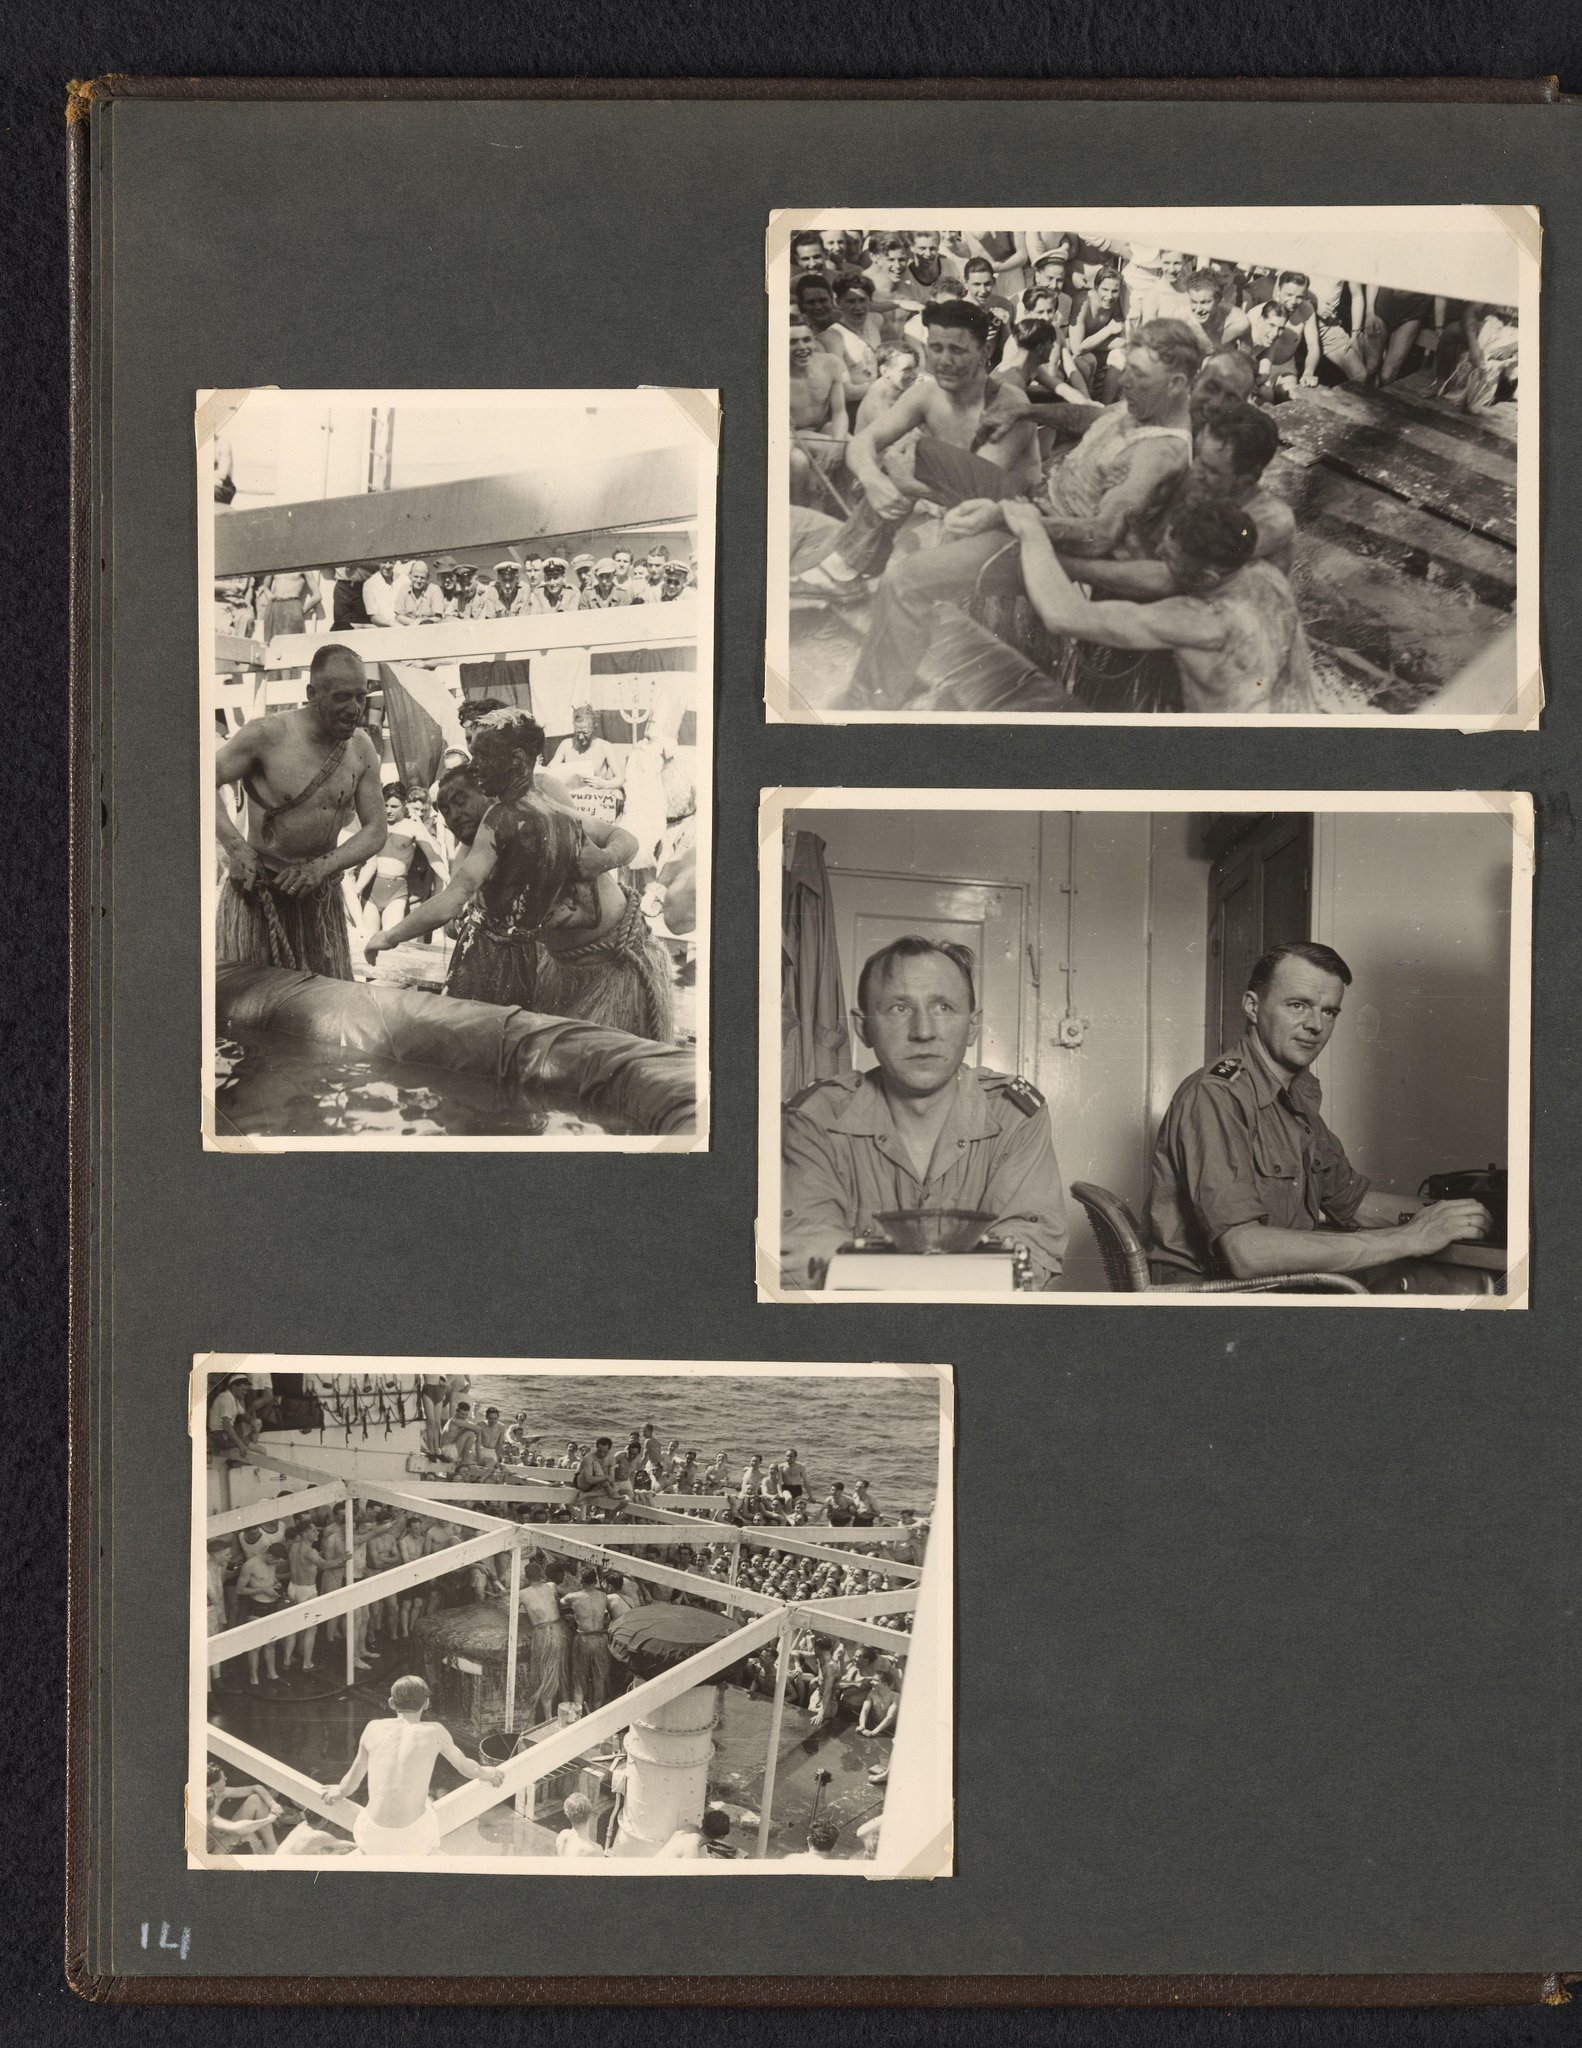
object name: album leaf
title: Aan boord vieren van het passeren van de evenaar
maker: Anonymous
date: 1947-1948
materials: cardboard, photographic support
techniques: gelatin silver print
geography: equator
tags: the company, the unit, the troop ~ military service, man dressed as woman, travesty, celebration on board while crossing the equator (neptune)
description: Albumblad met vier foto's van het vieren van het passeren van de evenaar aan boord van het schip de S.S. Waterman, onderweg naar Nederlands-Indië. Ook portret van twee officieren. Onderdeel van het fotoalbum 'Mijn jaren in Indië' met foto's over de militaire acties in Nederlands-Indië.